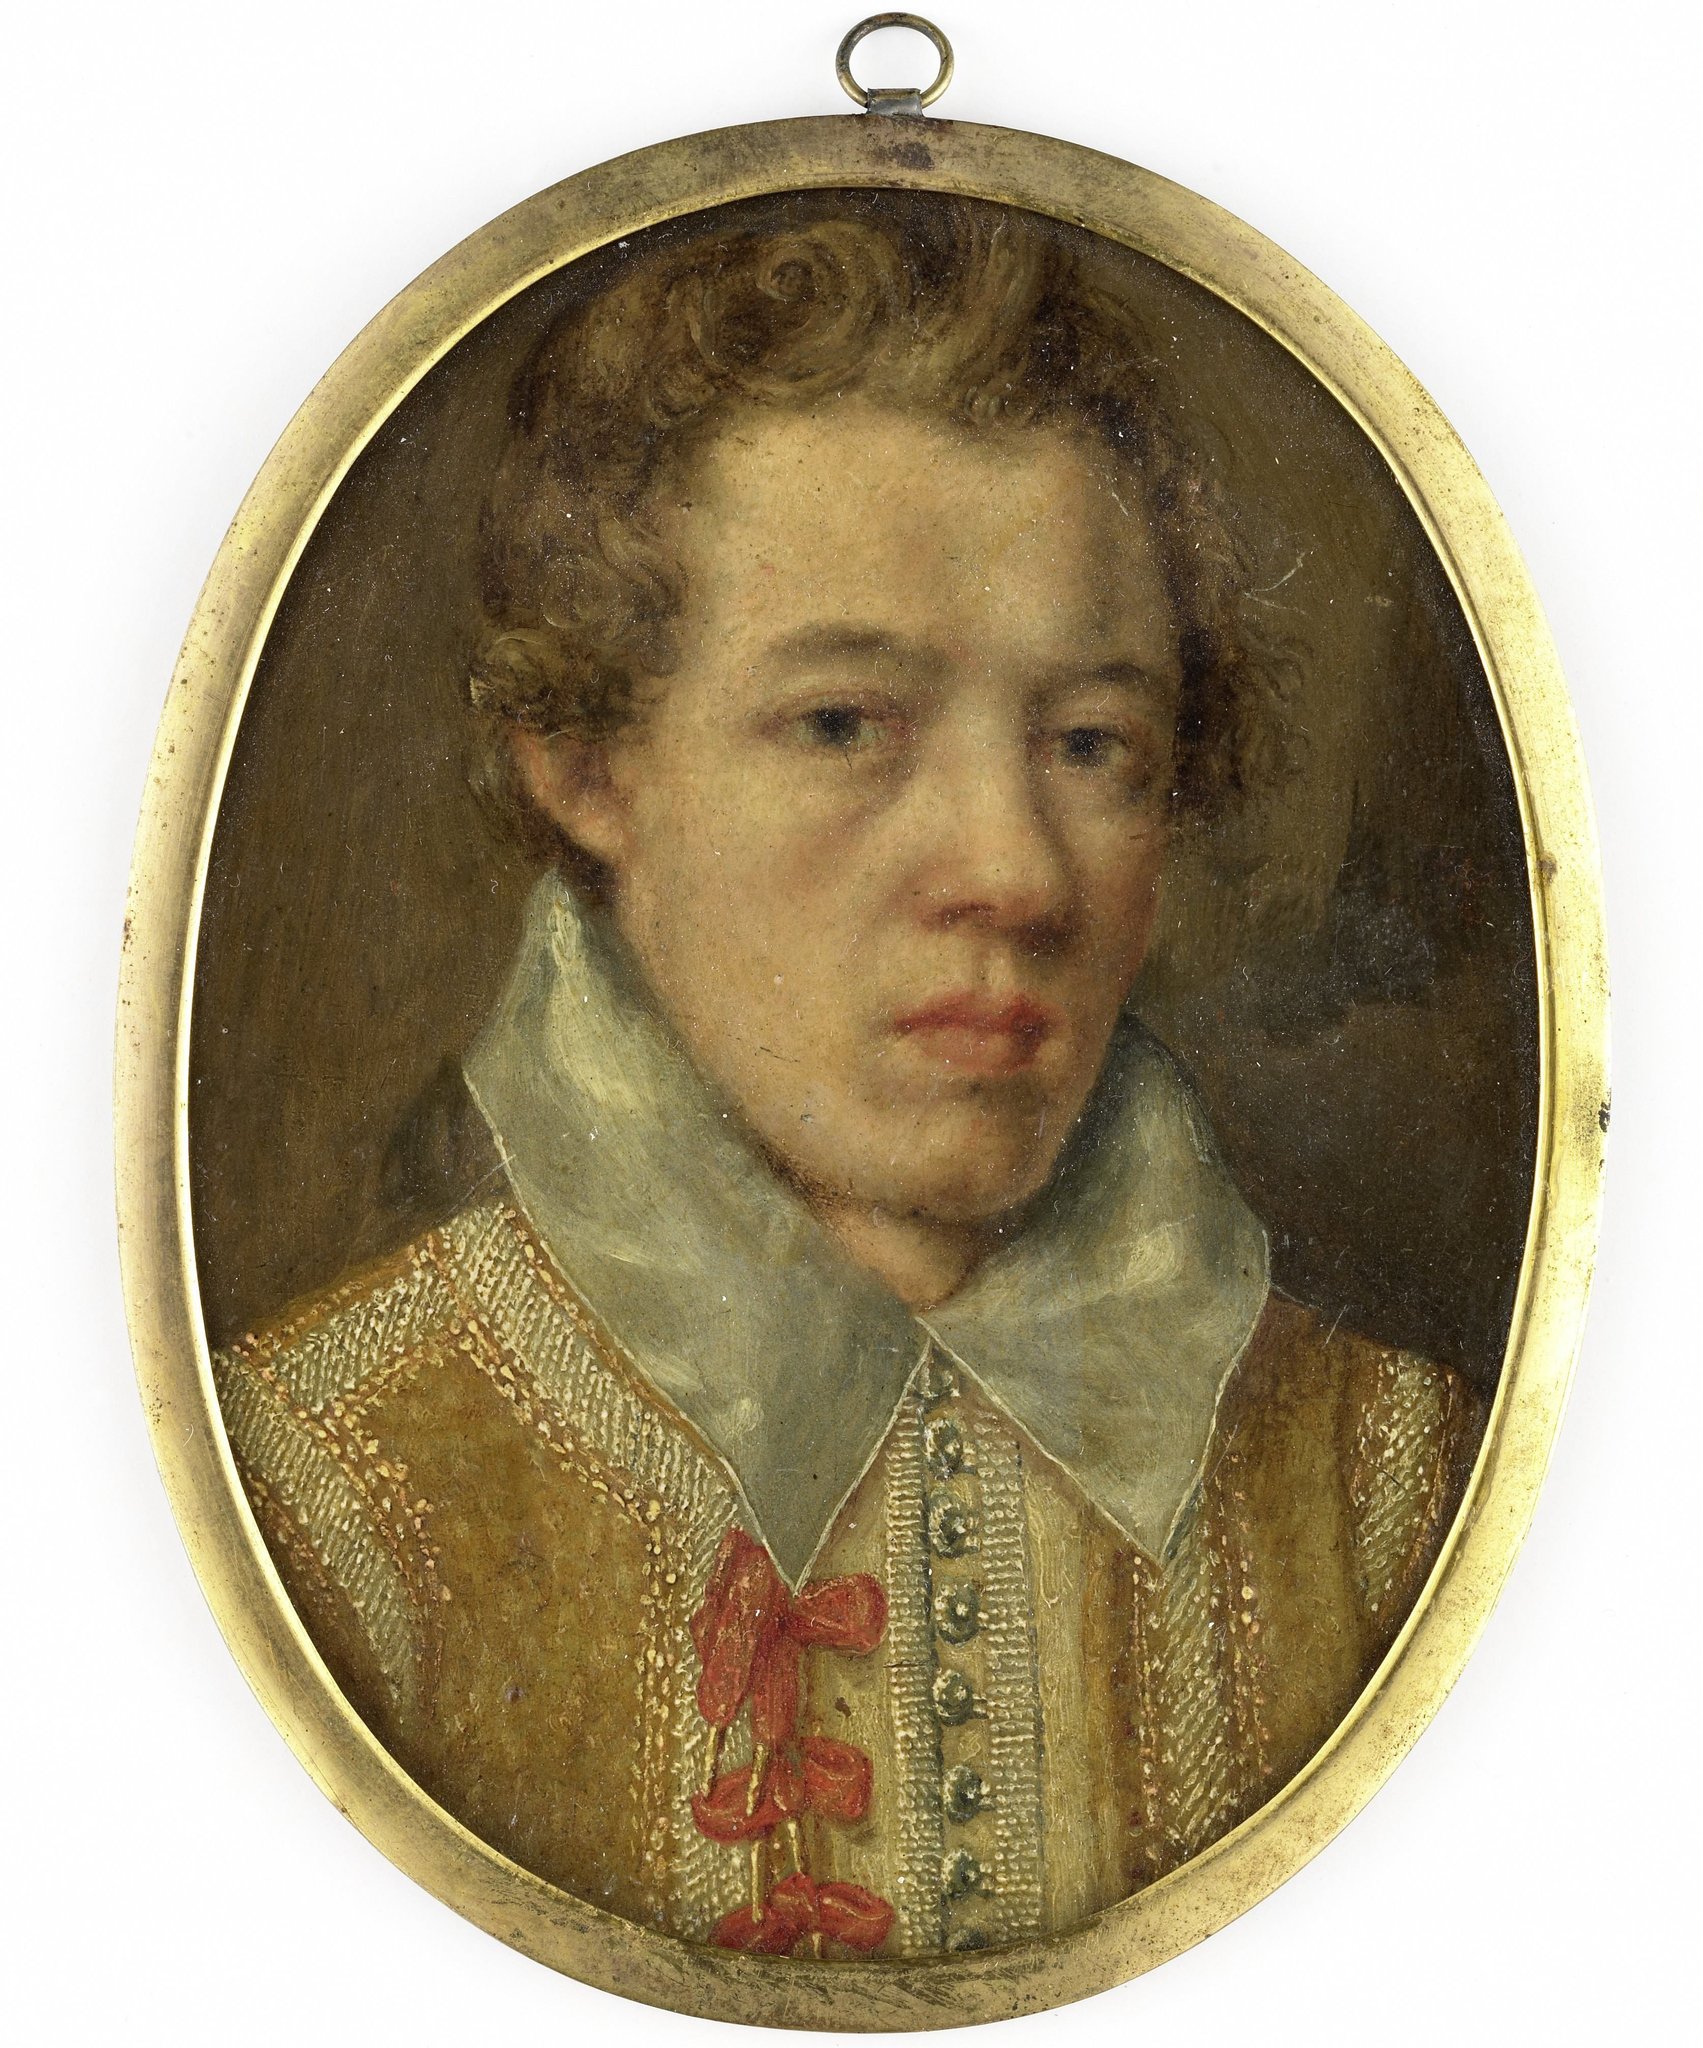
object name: painting, miniature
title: Portret van een jonge man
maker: franz kessler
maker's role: painter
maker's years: 1580-1650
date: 1600-1650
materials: copper, oil, silver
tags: historical persons not known by name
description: Portret van een jonge man. Buste, iets naar rechts. Onderdeel van de collectie portretminiaturen.